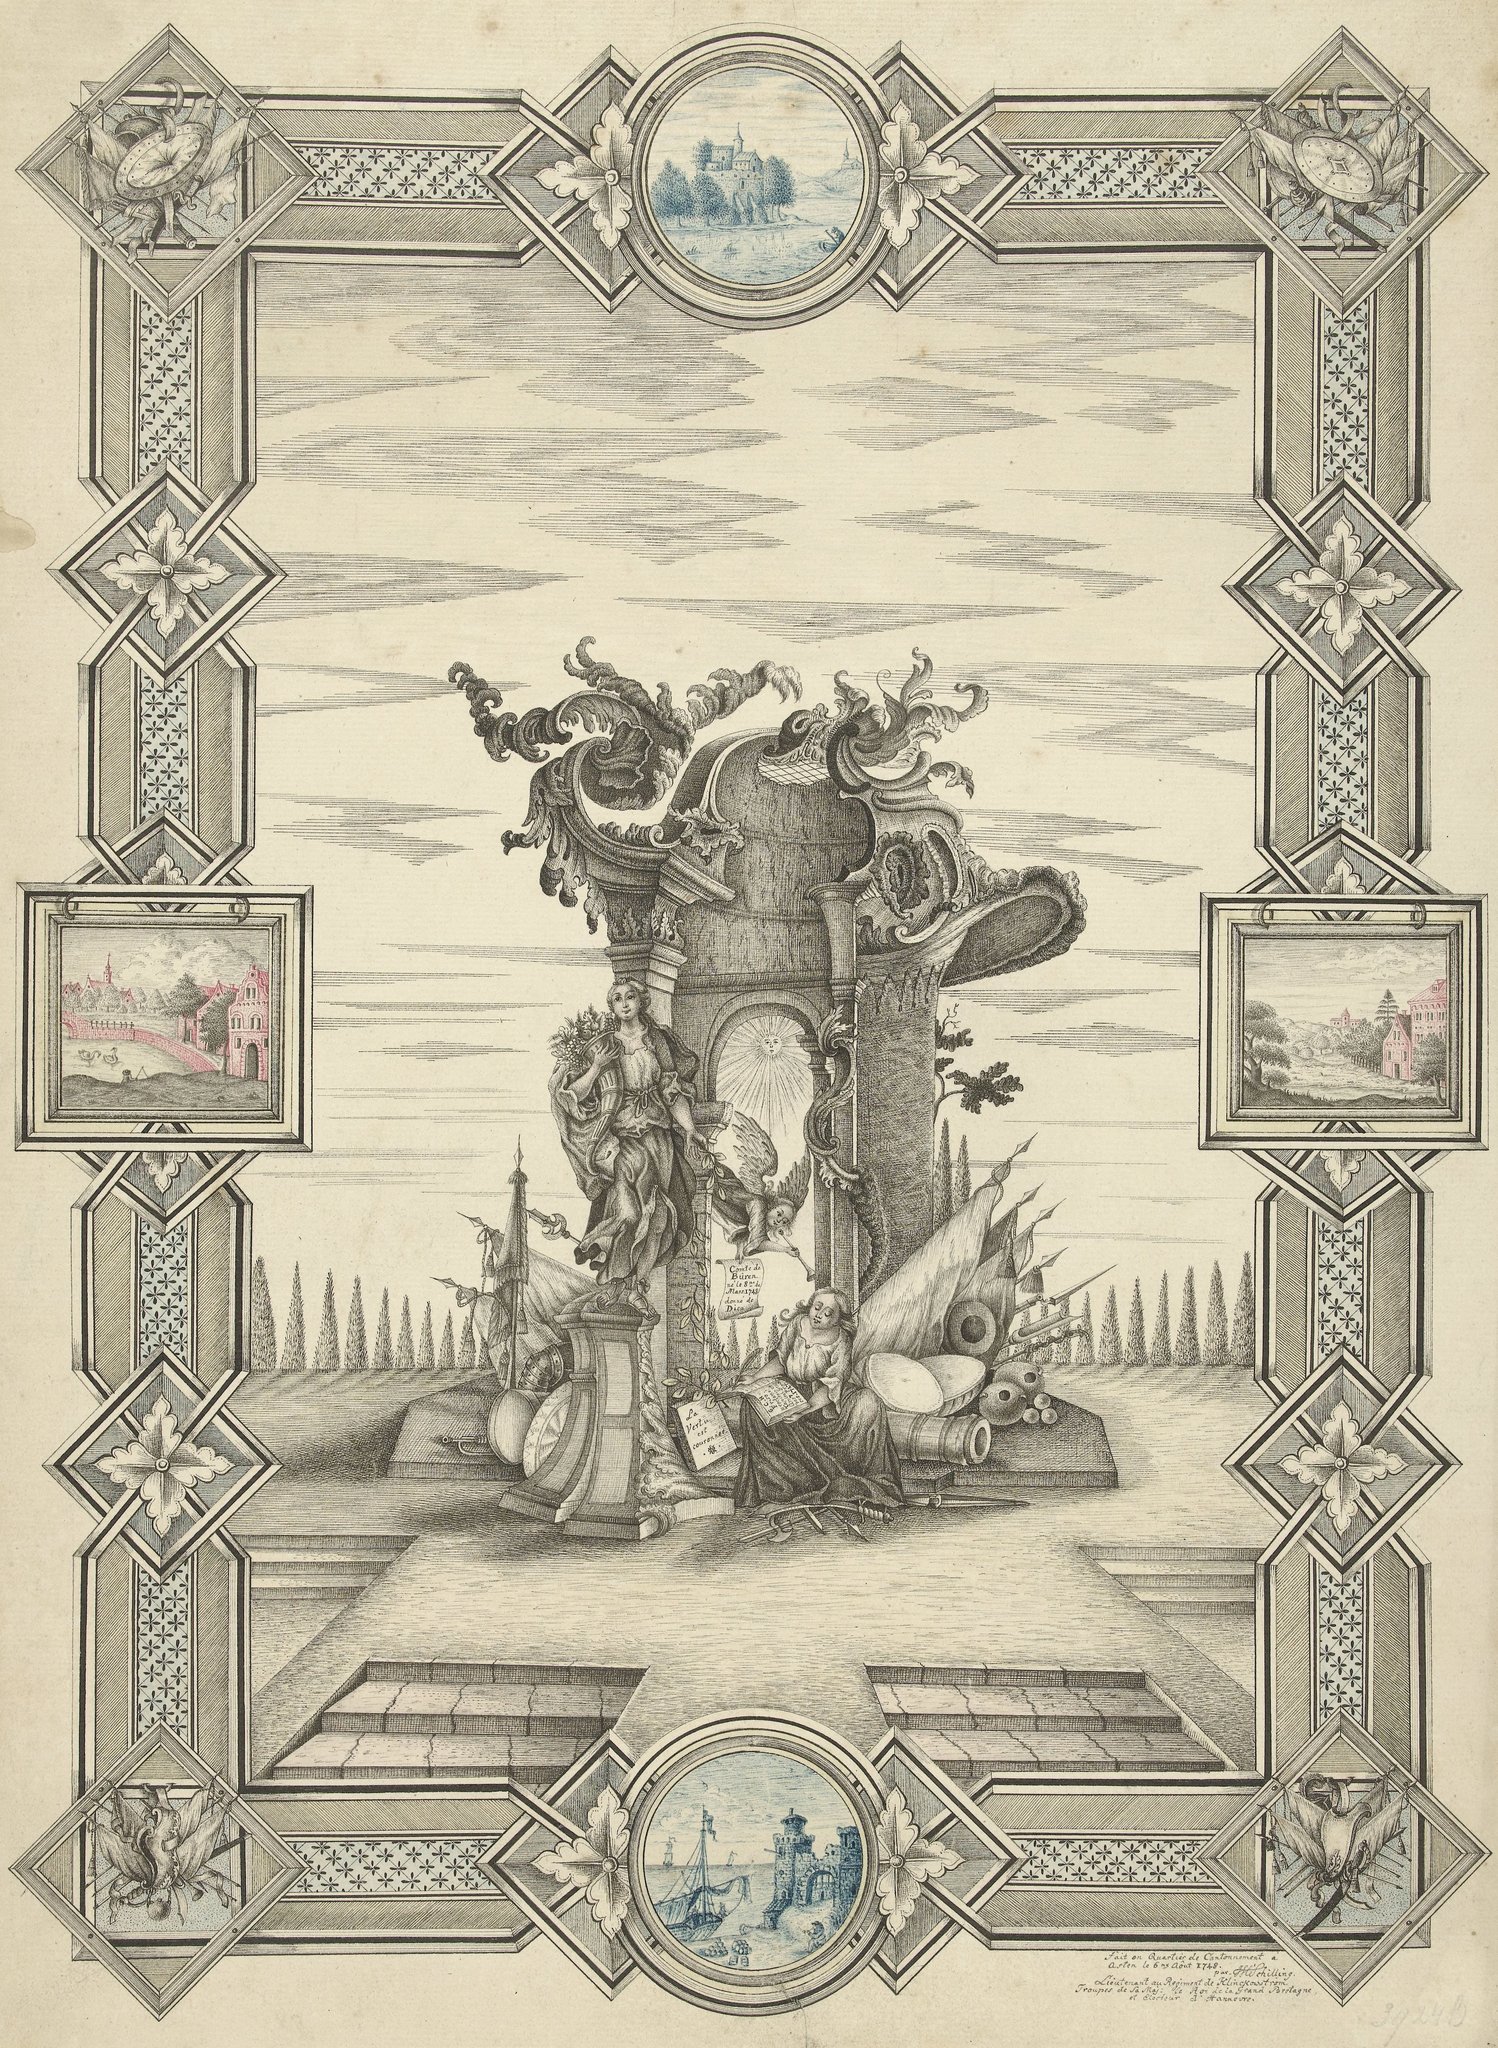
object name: drawing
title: Allegorie op de geboorte van de prins van Oranje, 1748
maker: j.h. schilling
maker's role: militair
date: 1748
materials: paper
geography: northern netherlands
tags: william v (prince of orange), symbols, allegories of peace, 'pax'; 'pace' (ripa), 'historia'; 'historia' (ripa), fame; 'fama', 'fama buona', 'fama chiara' (ripa)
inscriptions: signature: ‘fait en Quartier de Cantonnement à Asten le 6me Aôut 1748. par JHSchilling. Lieutenant au Regiment de Klinckowström Troupes des Sa Maj: le Roi de la Grand Bretagne et Electeur d'Hannovre’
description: Allegorie op de geboorte van Willem V, de graaf van Buren, prins van Oranje, 8 maart 1748. In een tempel schrijft de Geschiedenis de geboorte van de prins in haar boek, het nieuws van de geboorte wordt haar gebracht door de Faam. Op een voetstuk staat de Vrede met een hoorn van overvloed. Het dak van de tempel is versierd met rocaillemotieven. Voorstelling in een omlijsting met kleine gekleurde plaatjes van landschappen en wapentrofeeën.